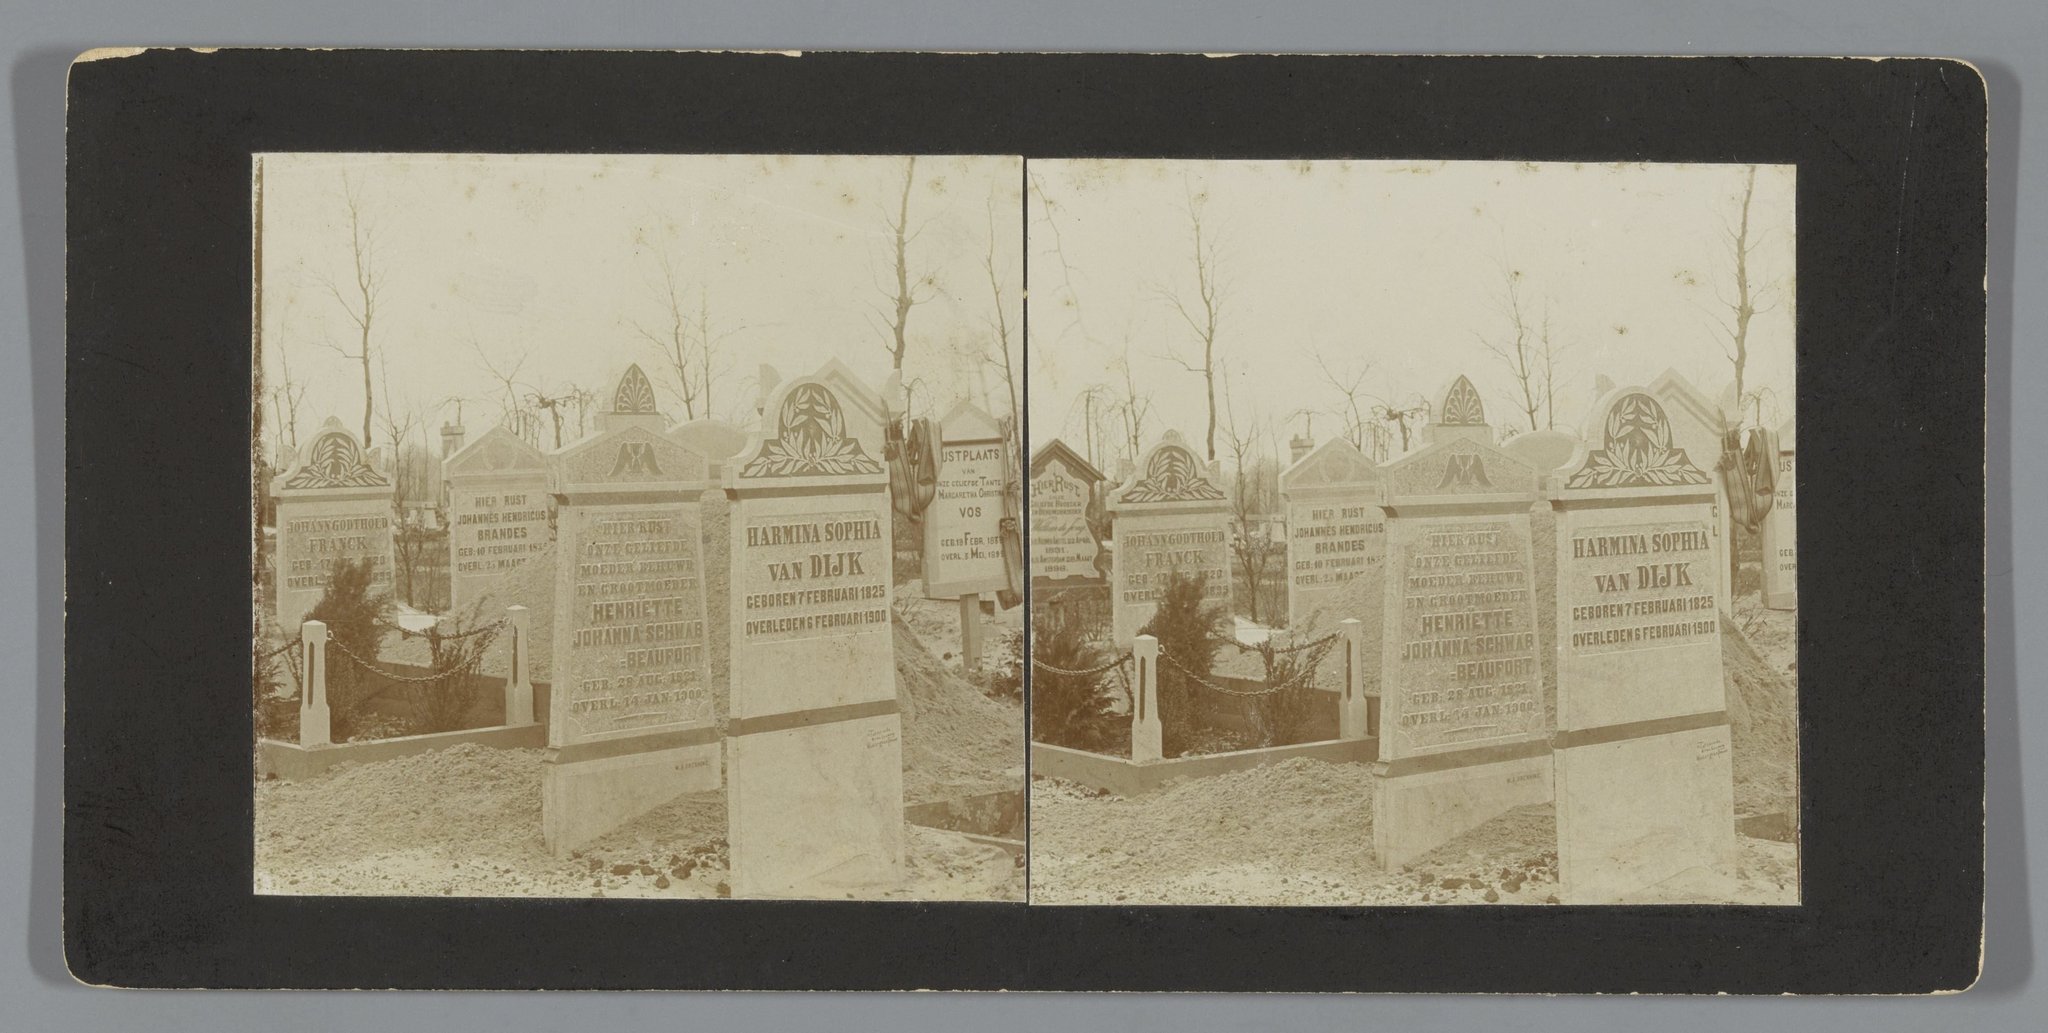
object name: stereograph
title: Graven op een begraafplaats in Nederland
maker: Anonymous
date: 1880-1920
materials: paper, cardboard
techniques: collodion silver print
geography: netherlands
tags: cemetery, park-like burying ground, netherlands